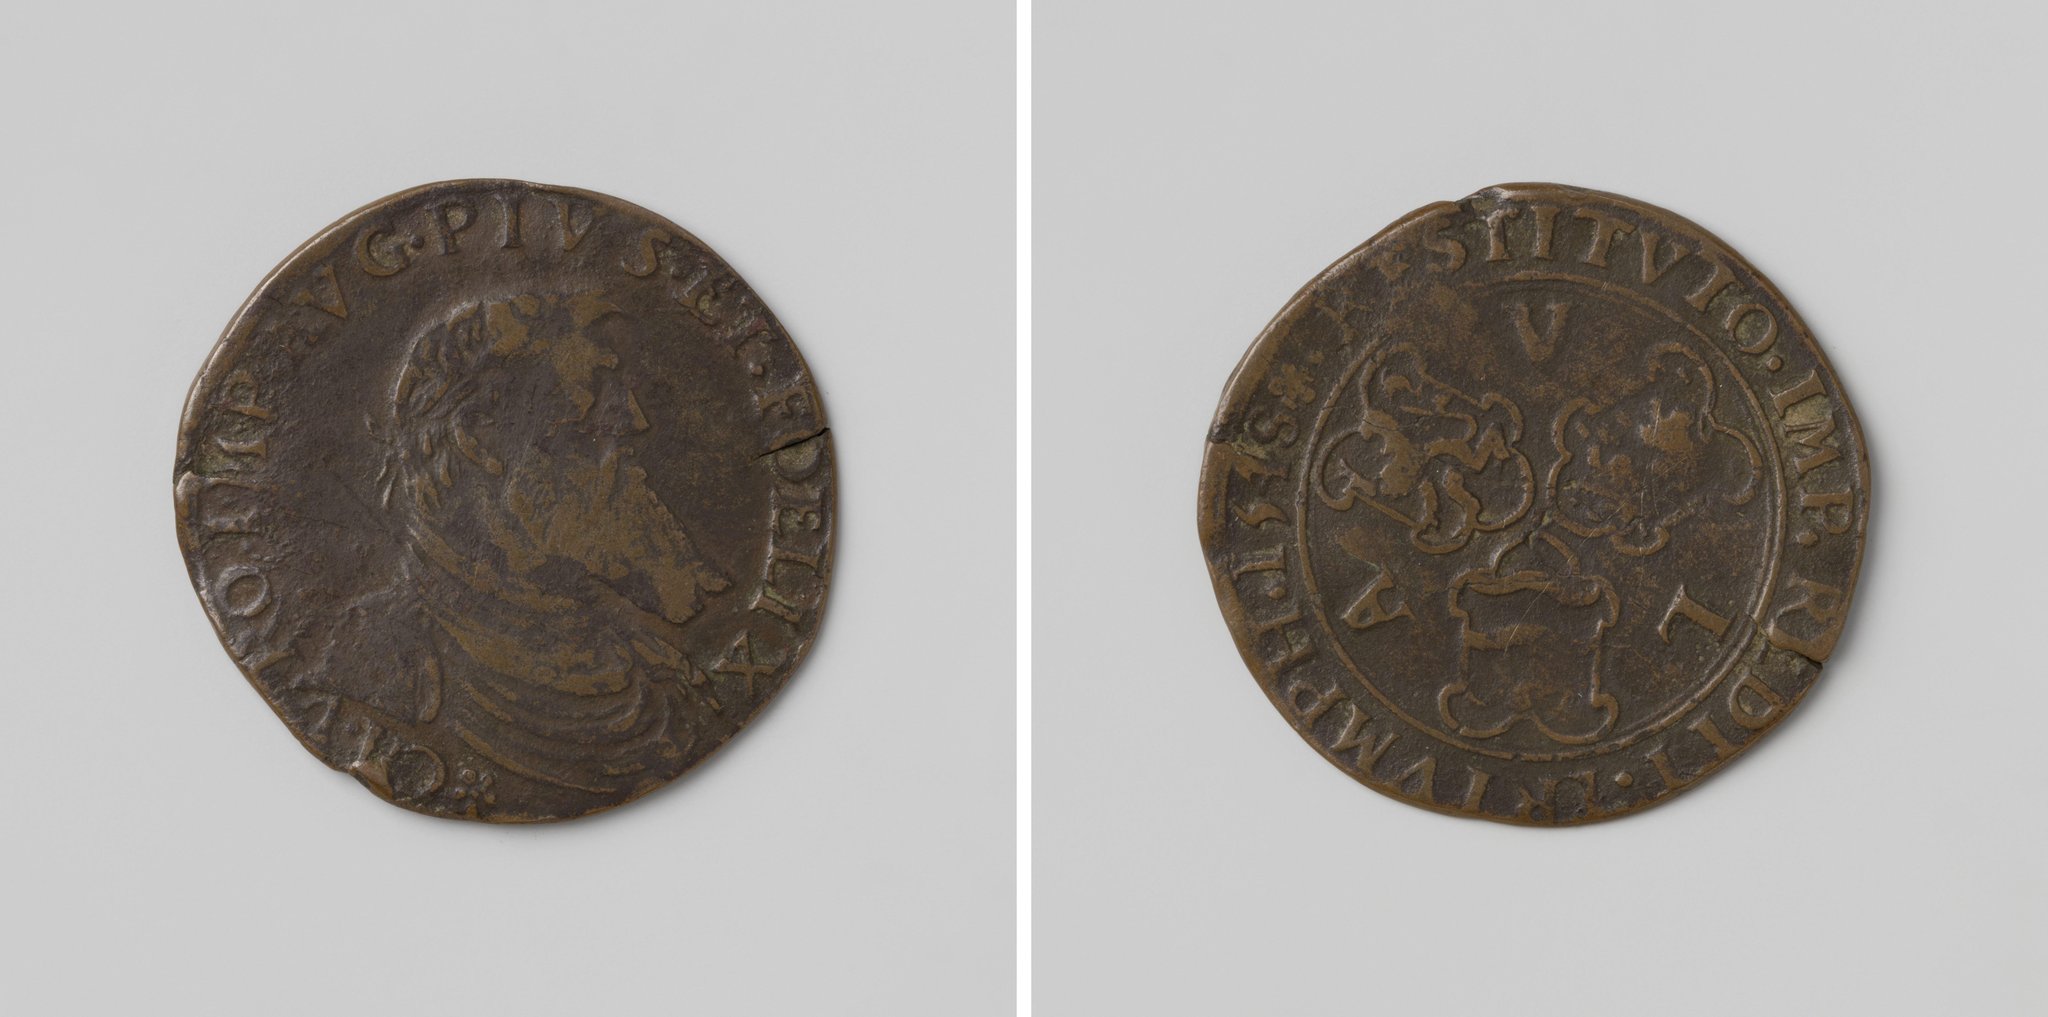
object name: jeton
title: Herstel van de vrede in Duitsland op het Interim van Augsburg, rekenpenning ten behoeve van Aelbrecht van Loo, auditeur van de rekenkamer van Holland te 's-Gravenhage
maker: Anonymous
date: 1548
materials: copper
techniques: striking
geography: netherlands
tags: ghent, charles v (holy roman emperor and king of spain), the hague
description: Koperen penning. Voorzijde: borststuk man met lauwerkrans binnen omschrift. Keerzijde: drie in kring geplaatste wapenschilden; daartussen letters A, V en L binnen omschrift